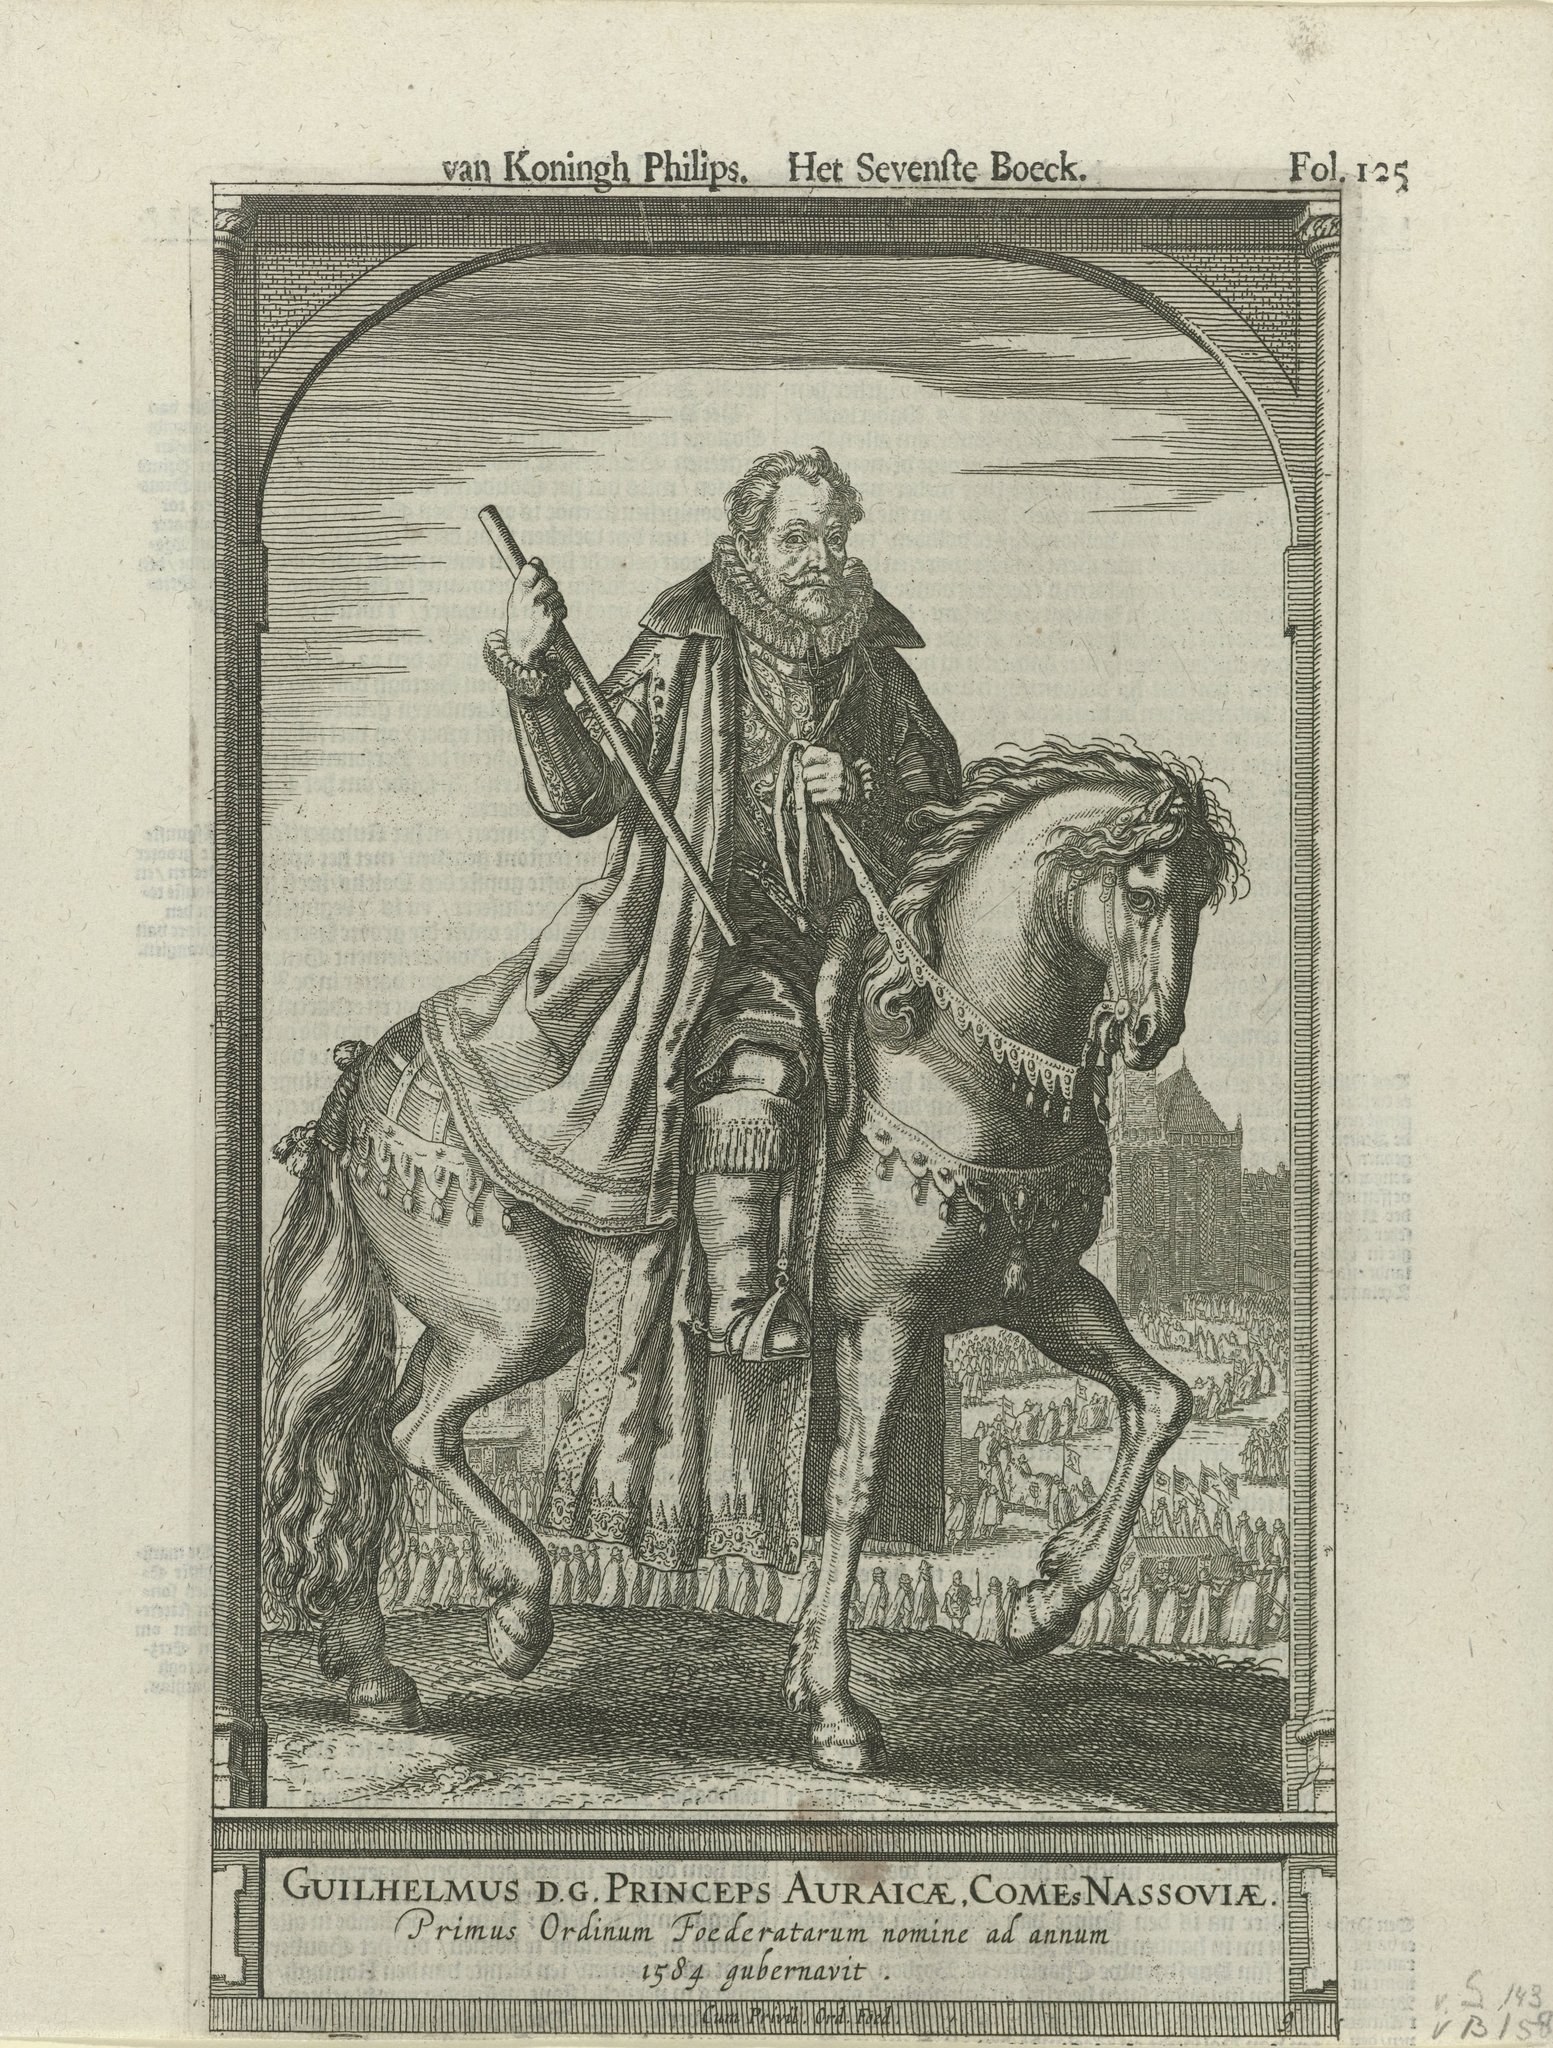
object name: print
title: Portret van Willem I, prins van Oranje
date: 1652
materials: paper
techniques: engraving, etching, letterpress printing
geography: low countries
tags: delft, william i (prince of orange)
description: De hier vermelde titel verwijst naar de hoogst verkregen titel van de geportretteerde, niet per se naar de titel die de geportretteerde op deze voorstelling draagt. Prent uit: Meteren, Emanuel van. Historien der Nederlanden, en haar naburen oorlogen tot het iaar 1612. Amsterdam: Jan Jacobsz Schipper, 1652 en 1663.